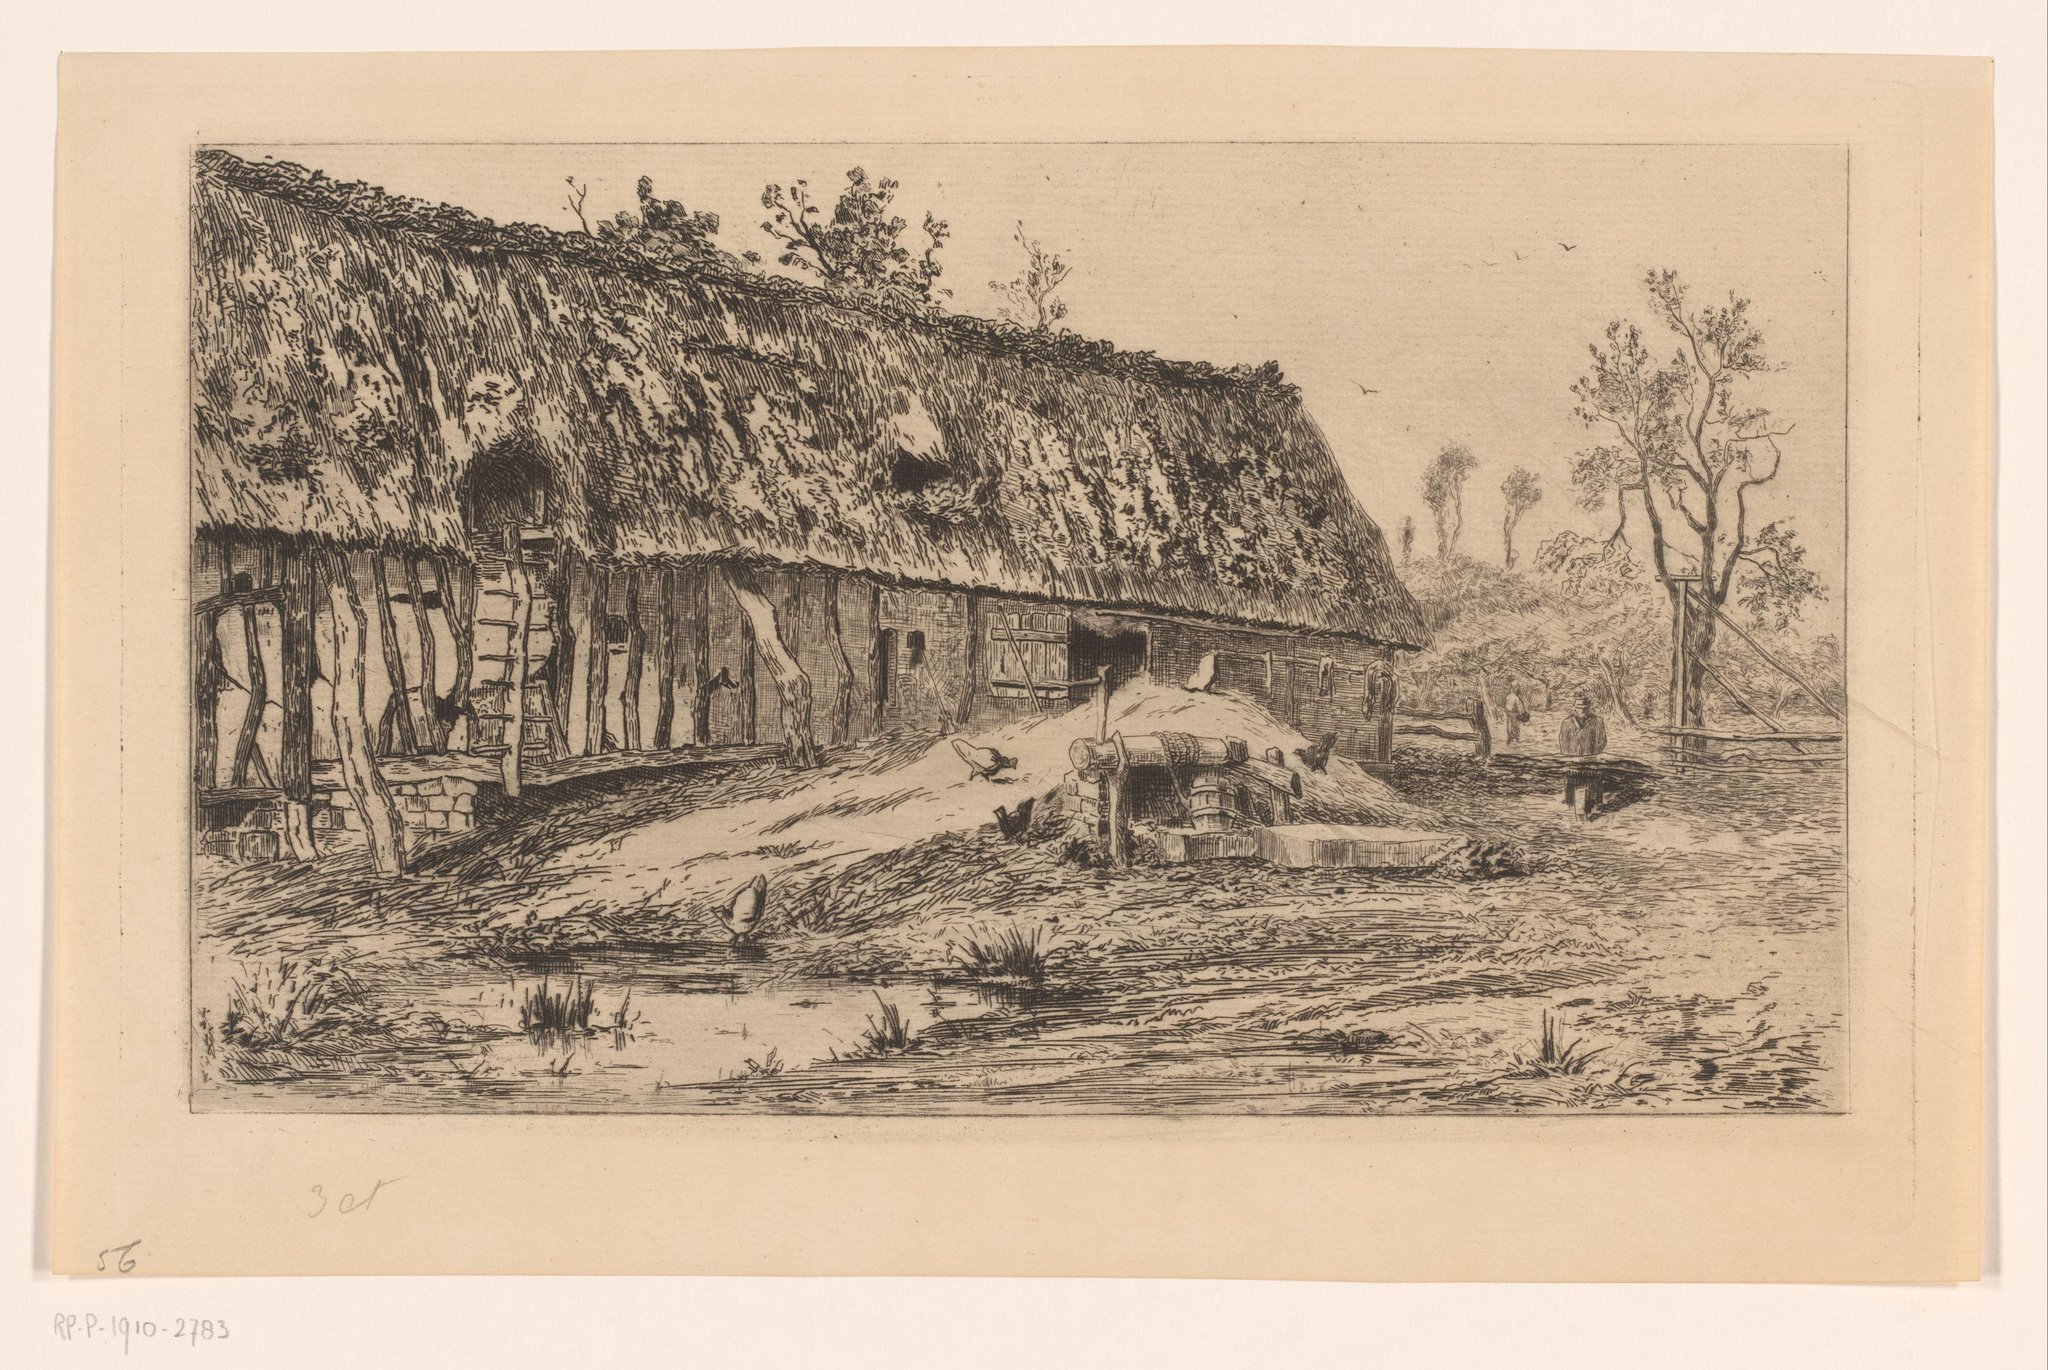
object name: print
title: Boerenerf in Veules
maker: carel nicolaas storm van s-gravesande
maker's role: draughtsman, print maker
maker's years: 1841-1924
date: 1851-1910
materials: paper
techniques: etching, intaglio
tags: farm (building)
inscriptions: collector's mark: Lugt 2228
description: Gezicht op een boerenerf met schuur en kippen.